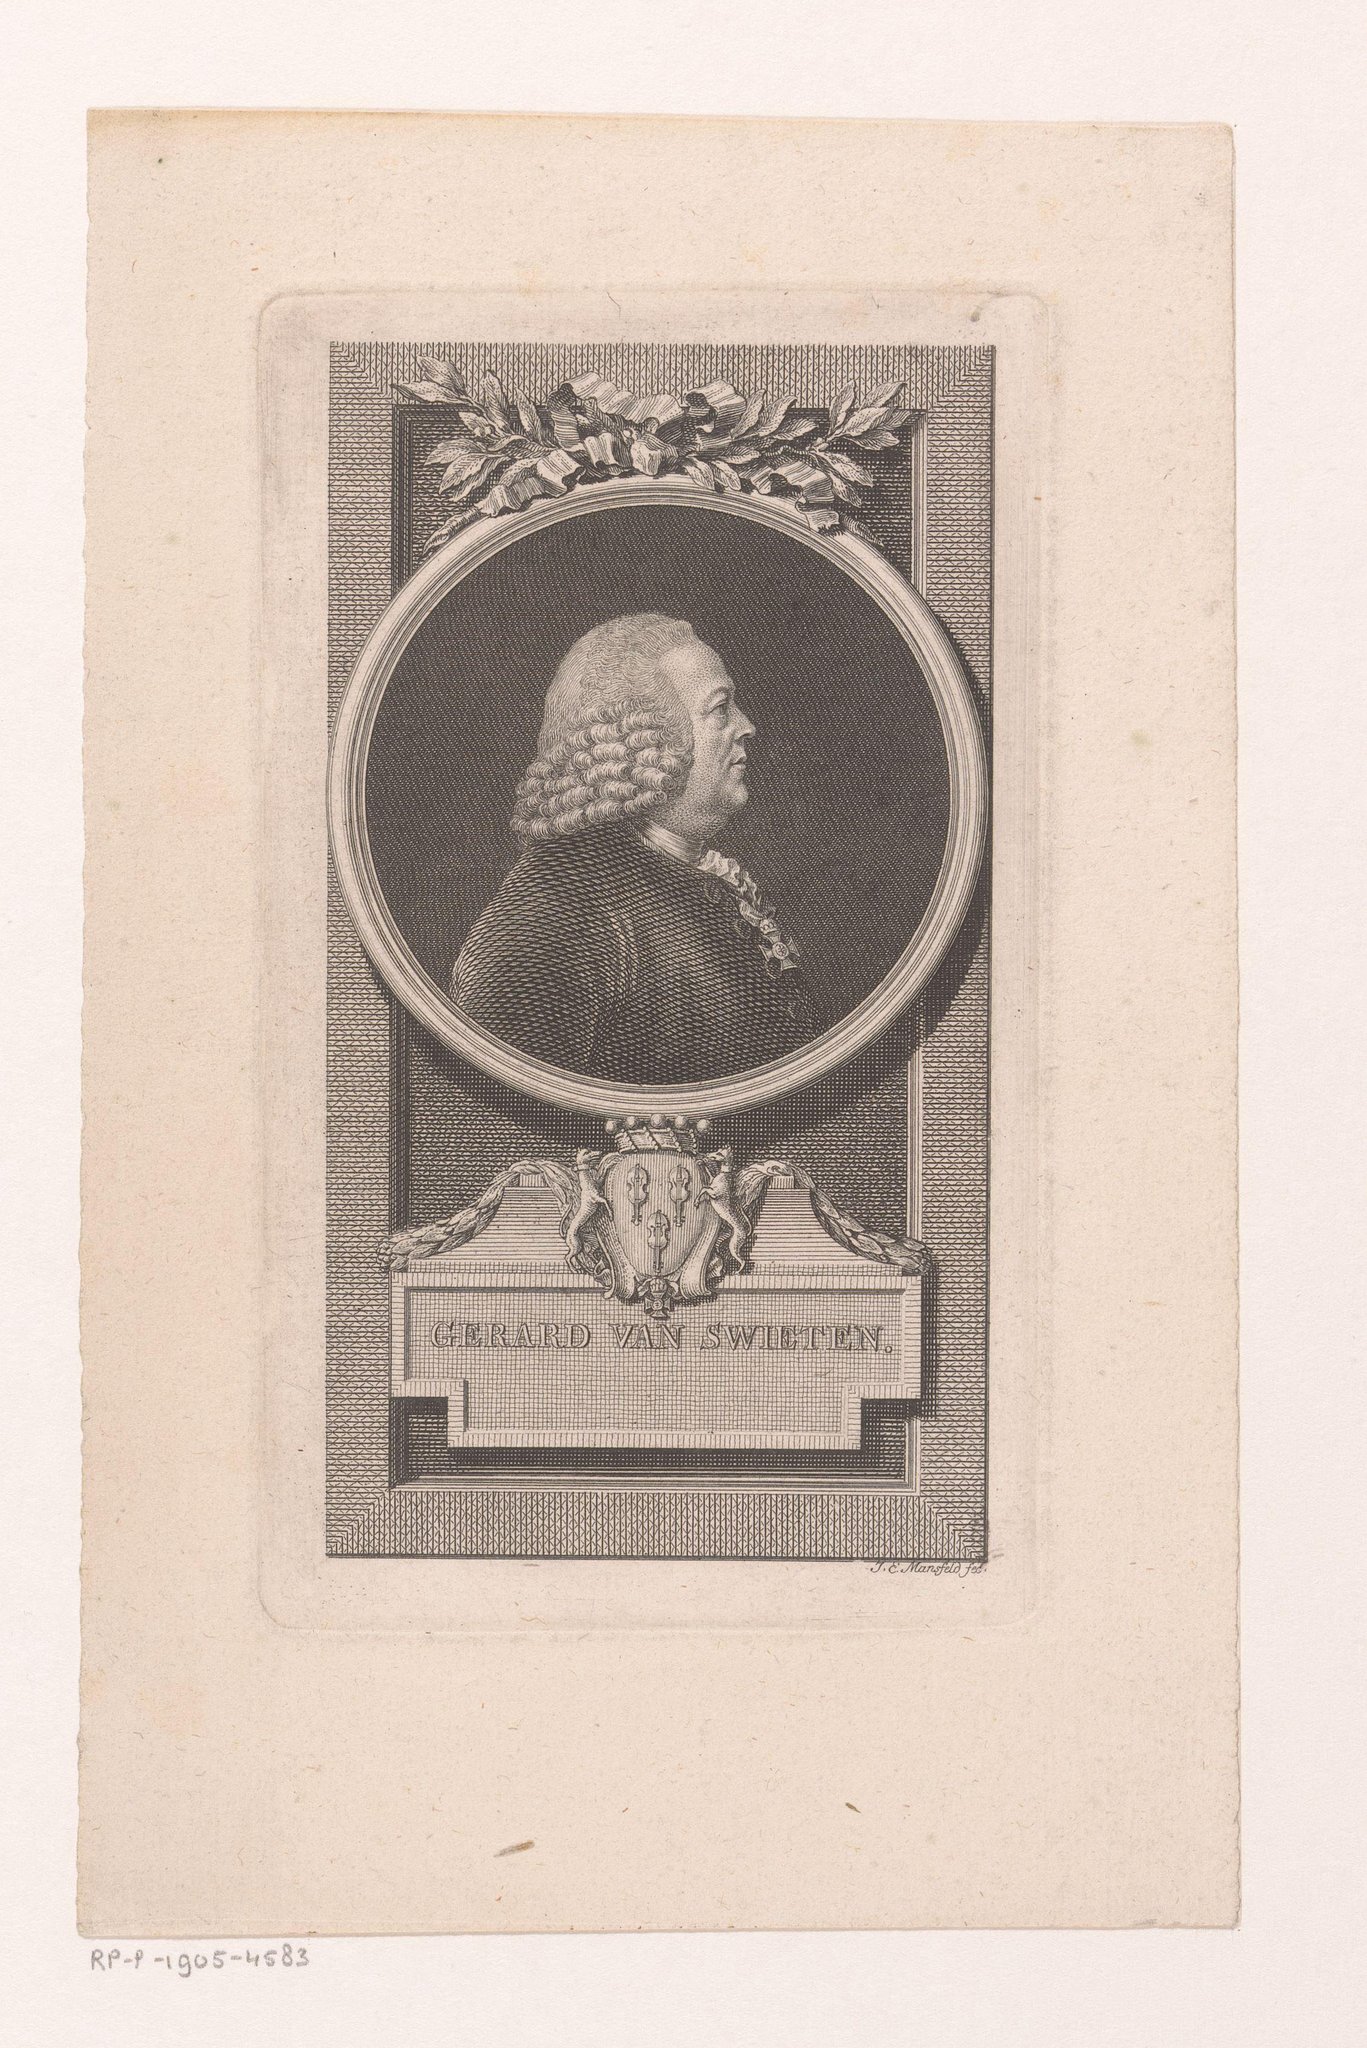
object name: print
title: Portret van Gerard van Swieten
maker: johann ernst mansfeld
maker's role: print maker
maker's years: 1739-1796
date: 1749-1796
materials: paper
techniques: engraving, etching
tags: leiden, vienna, historical persons, armorial bearing, heraldry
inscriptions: collector's mark: Lugt 2228